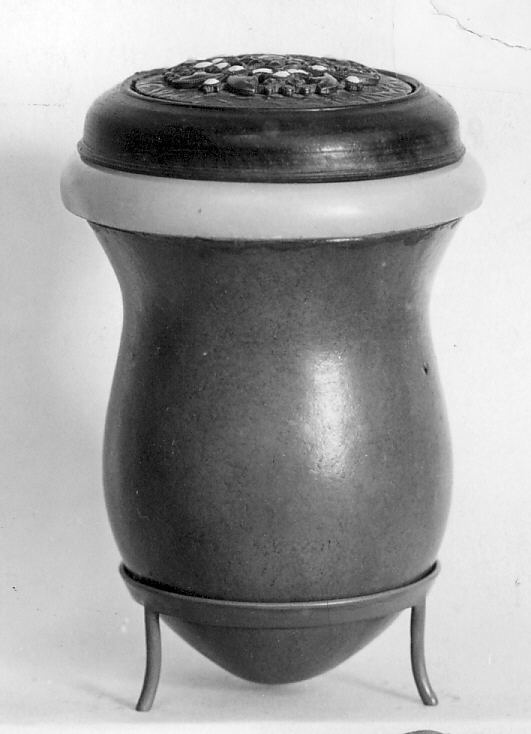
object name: cricket cage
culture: chinese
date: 1701-1900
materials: enamel, jade